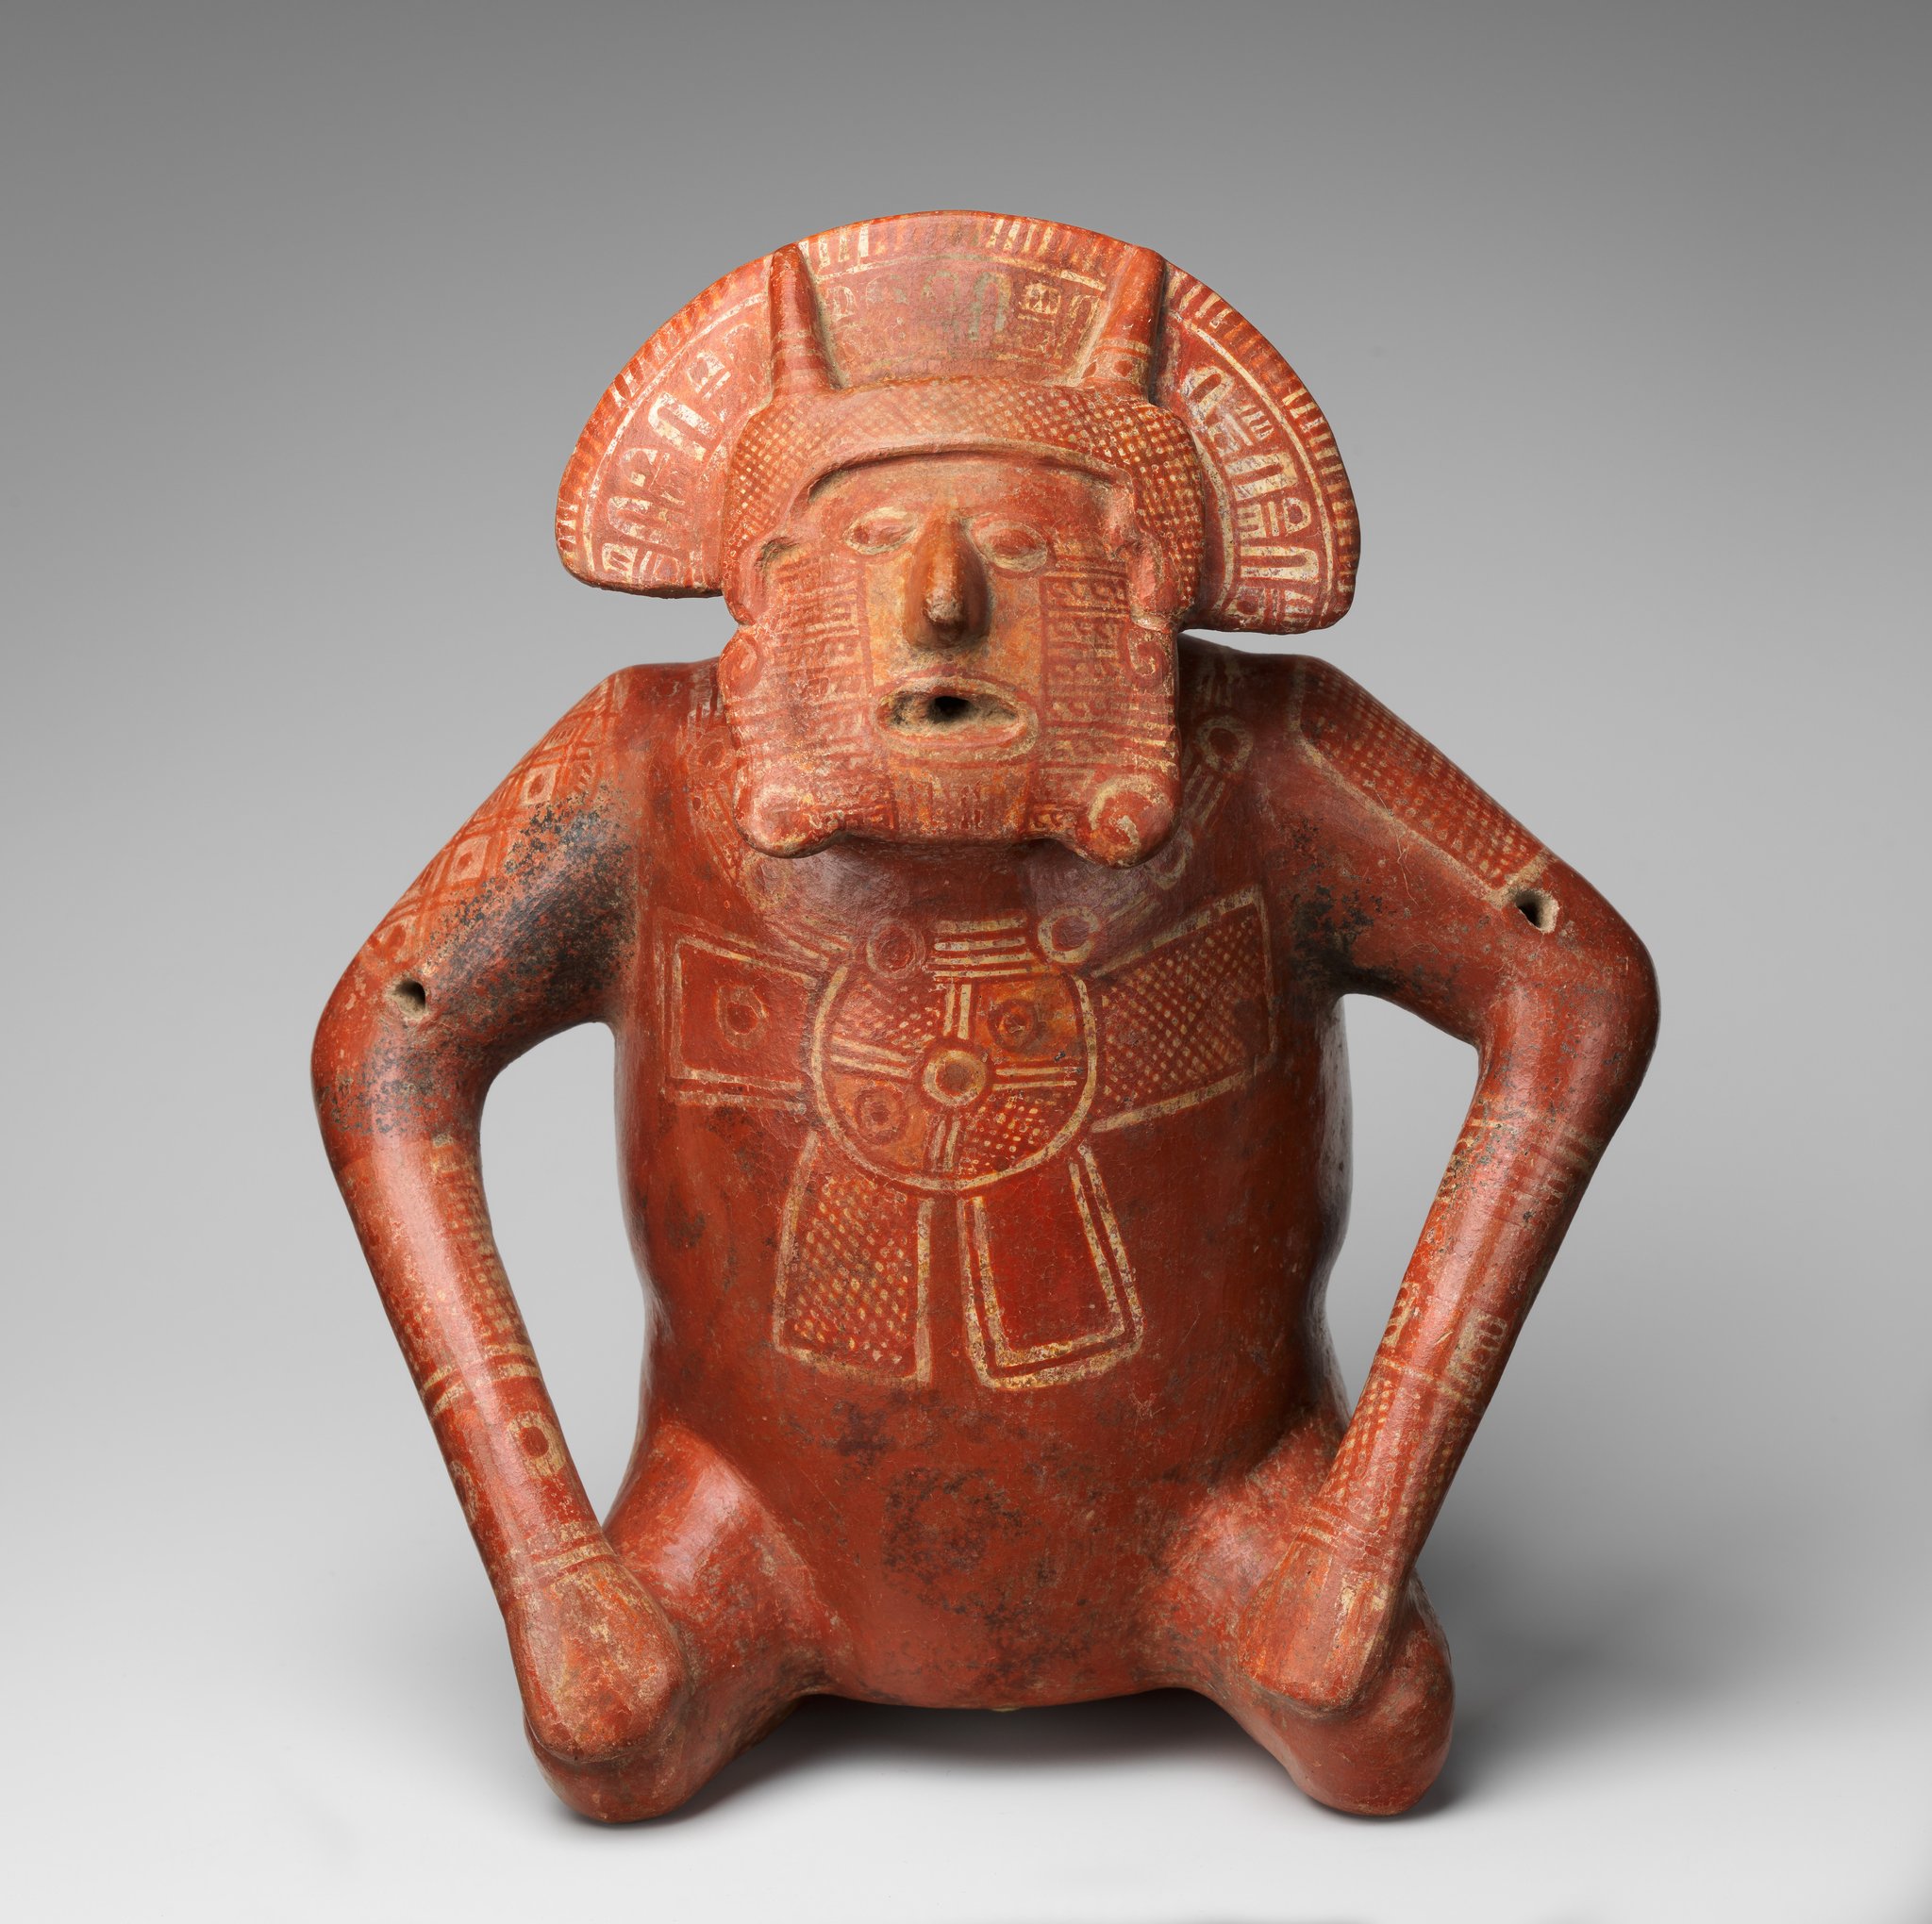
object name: vessel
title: Male effigy vessel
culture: colima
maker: colima artist(s)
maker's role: artist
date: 1200-1500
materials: ceramic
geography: mexico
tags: men